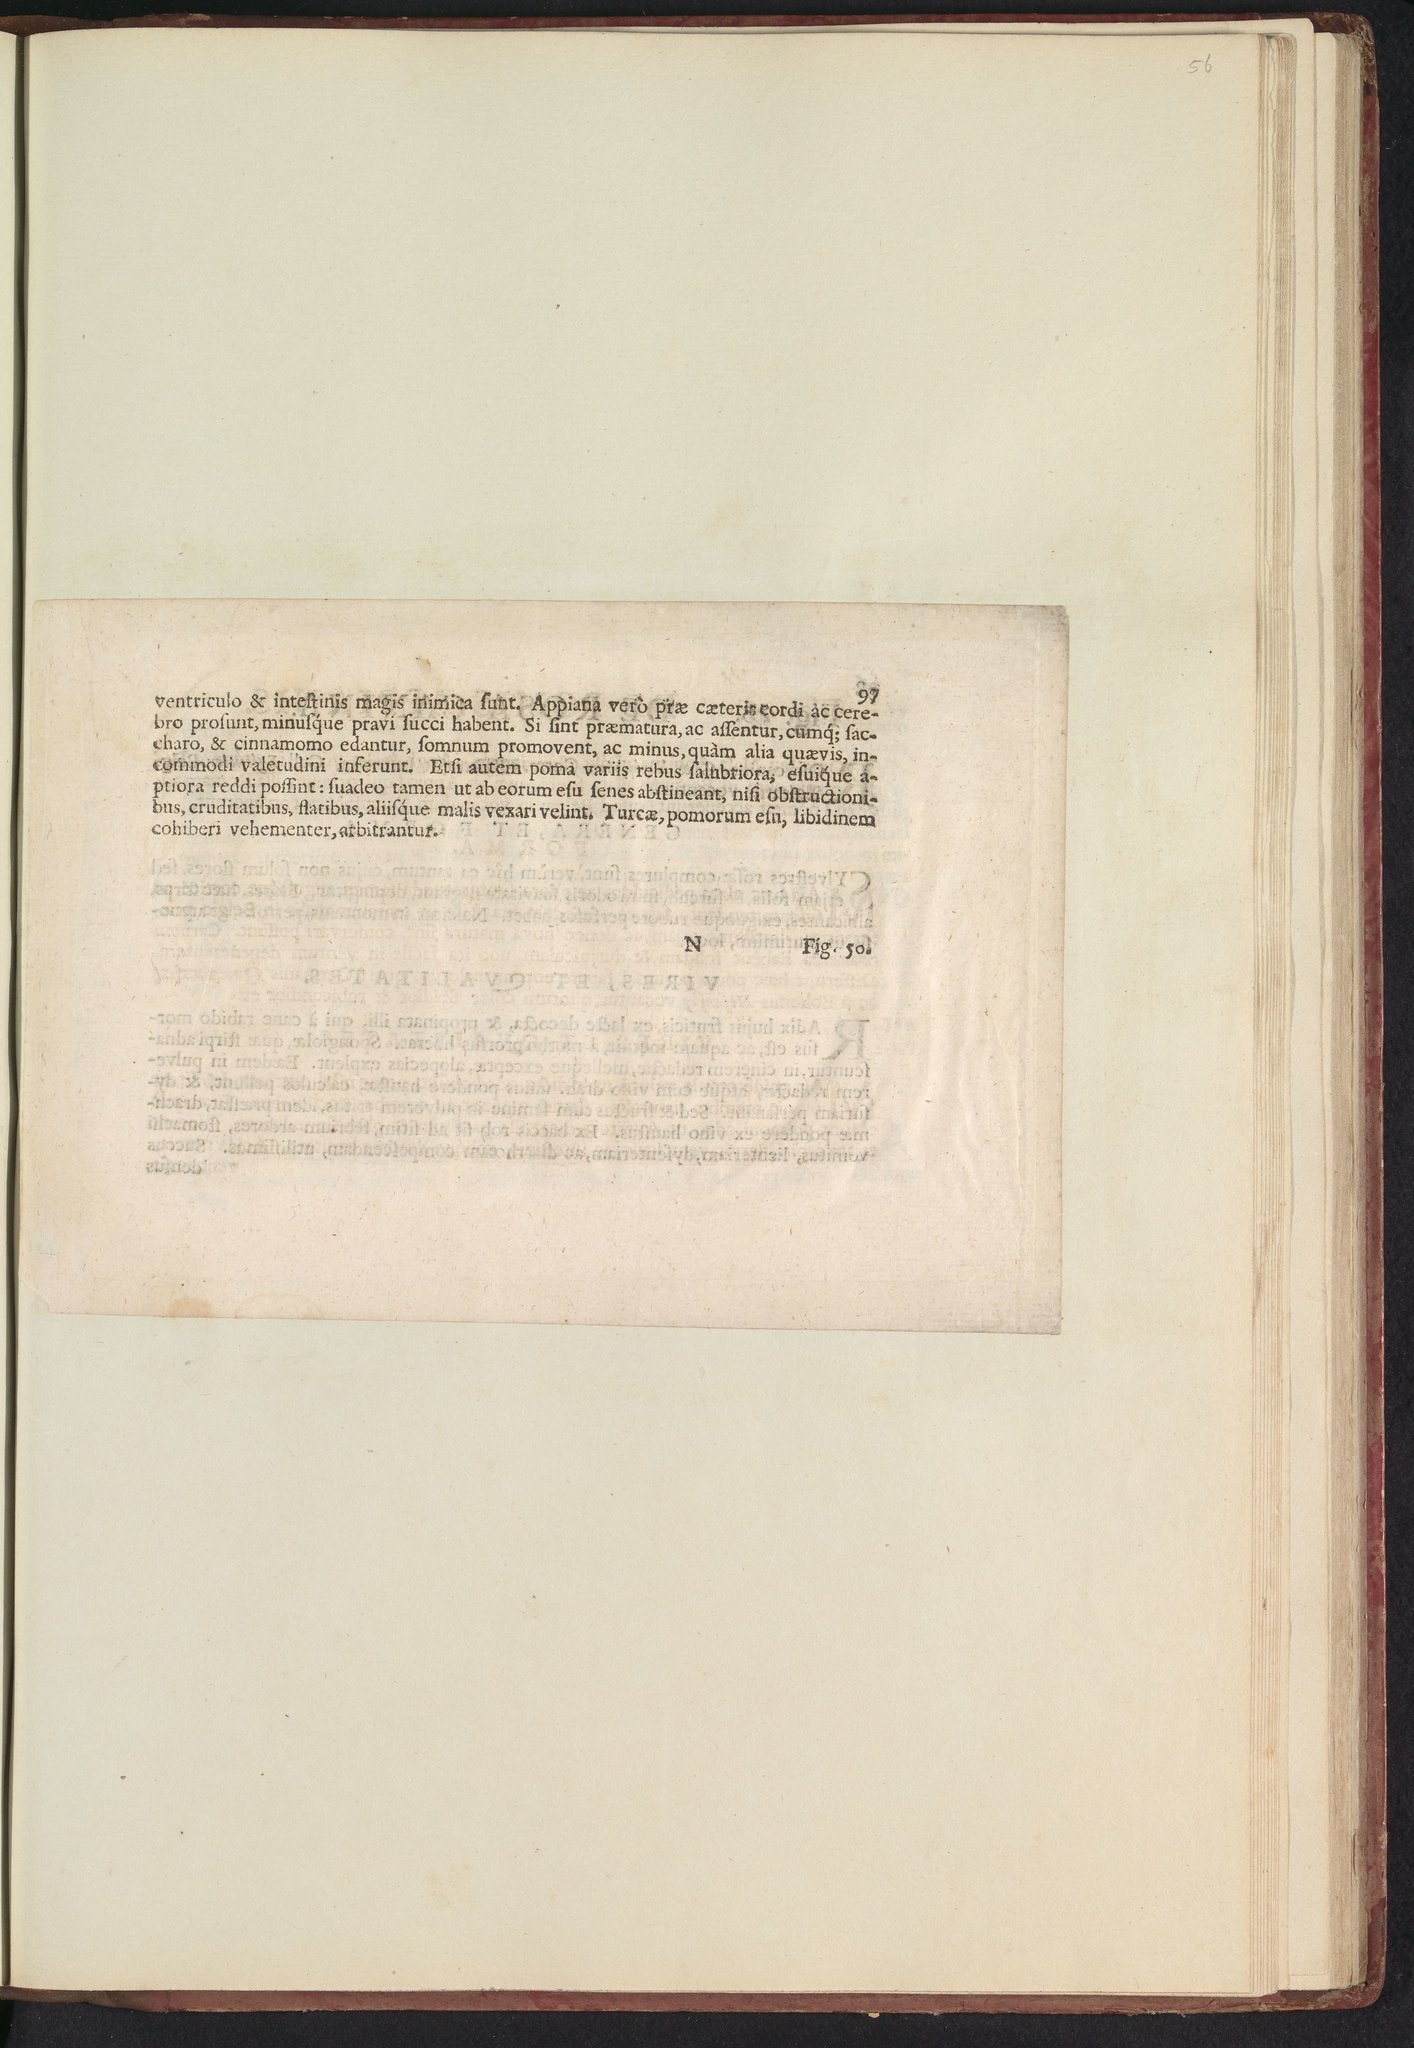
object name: text sheet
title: Fig. 49 'De Pomis Appianis' in De Boodts herbarium van 1640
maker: anselmus boëtius de boodt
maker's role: draughtsman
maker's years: 1550-1632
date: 1640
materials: ink, paper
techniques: letterpress printing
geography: bruges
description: Beschrijving bij Fig. 49 op p. 97 in: Anselmi Boëtii de Boot I.C. Brugensis & Rodolphi II. Imp. Roman. medici a cubiculis Florum, Herbarum, ac fructuum selectiorum icones, & vires pleraeque hactenus ignotæ. Onderdeel van het album met bladen en platen uit De Boodts herbarium van 1640. Het twaalfde van twaalf albums met aquarellen van dieren, vogels en planten bekend rond 1600, gemaakt in opdracht van keizer Rudolf II.